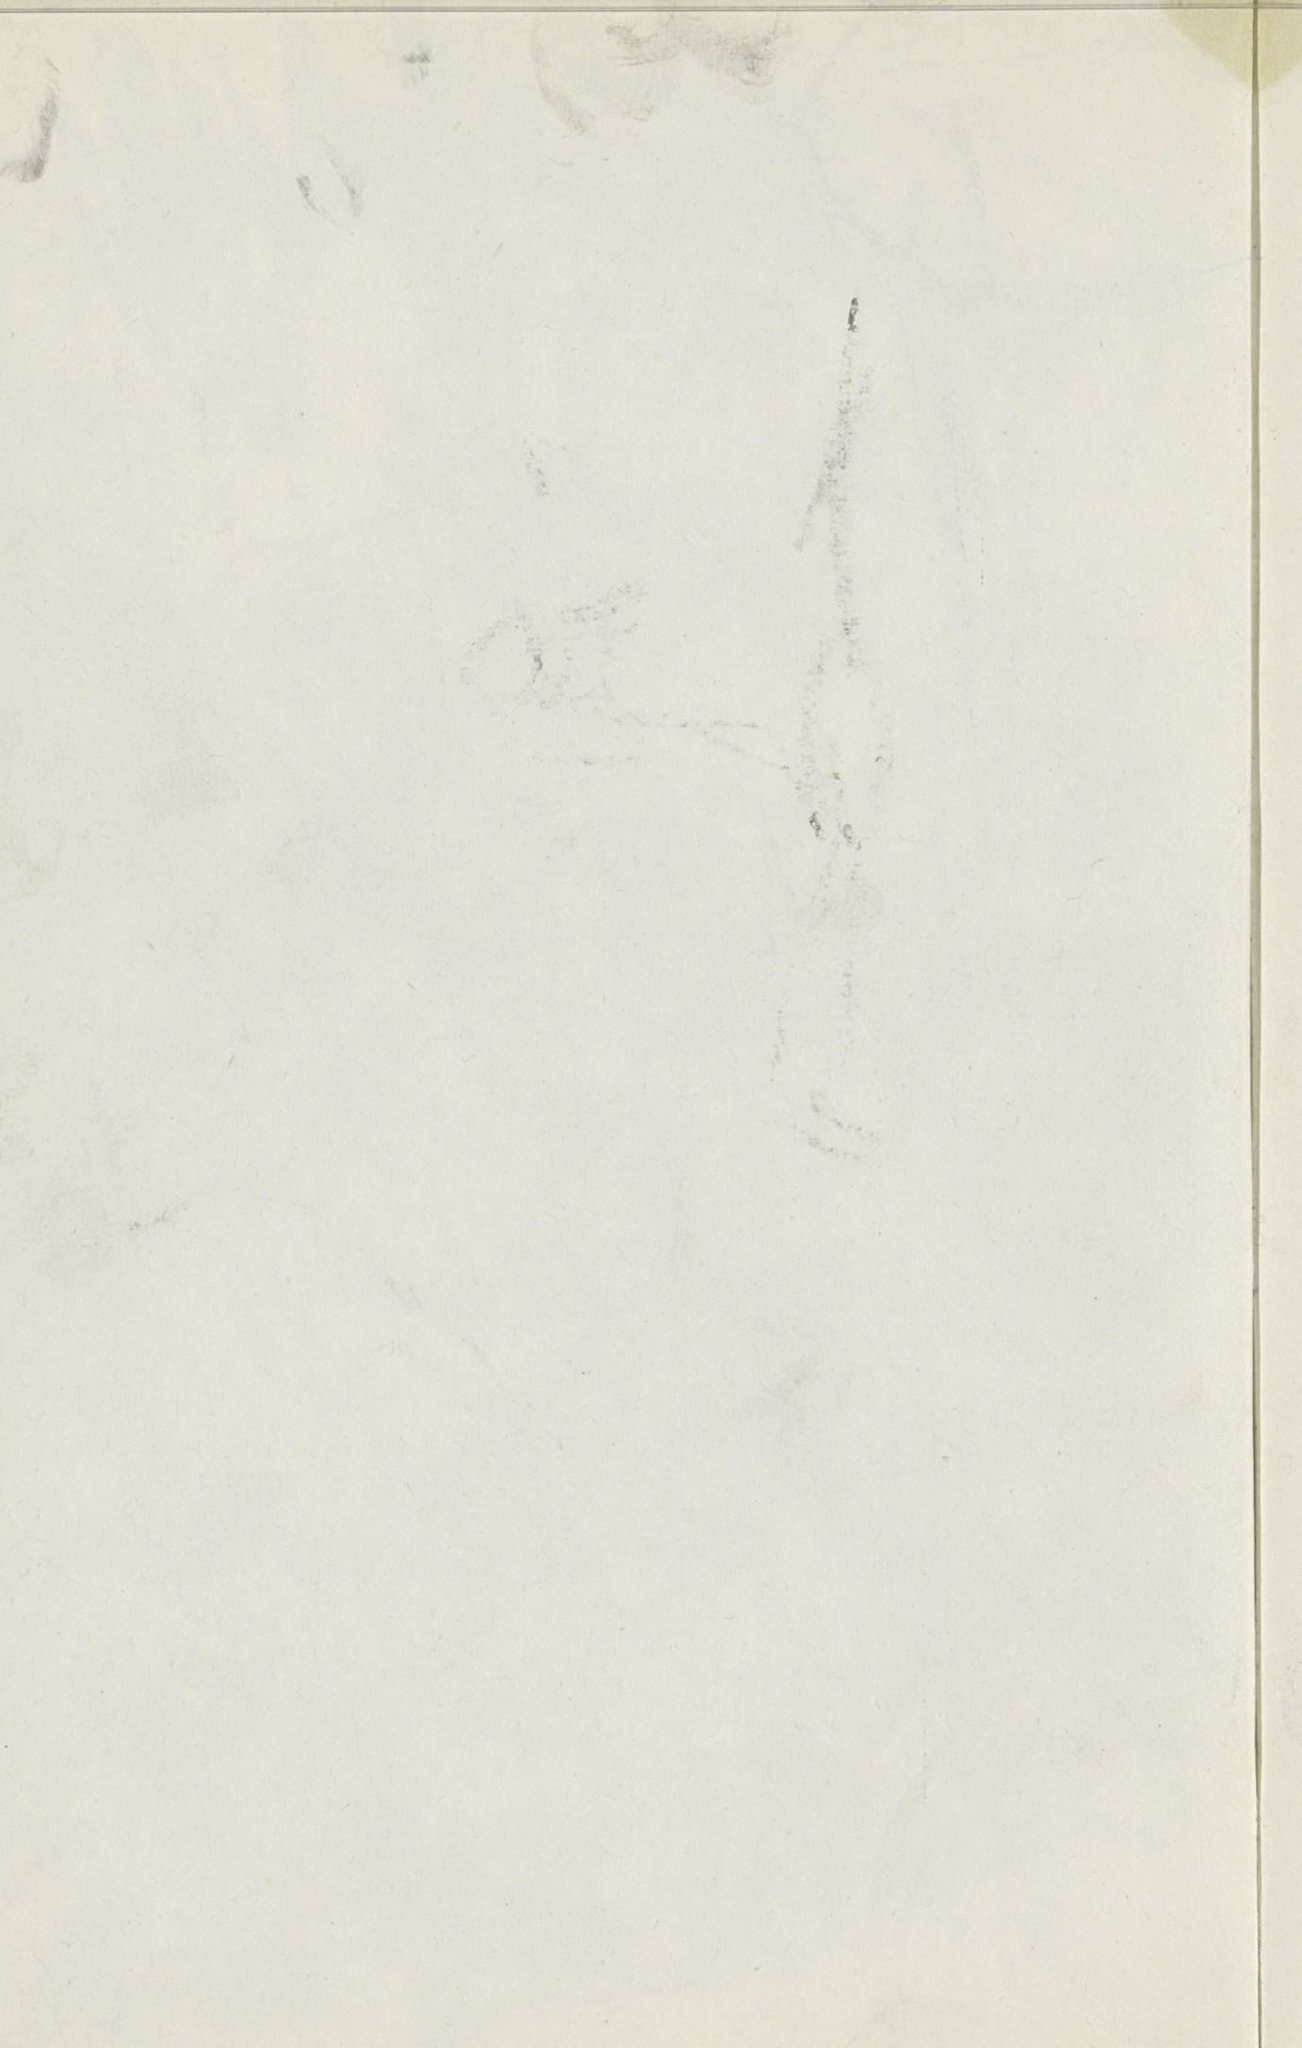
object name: sketchbook leaf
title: Ablatsch van de krijttekening op blad 18A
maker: isaac israels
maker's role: draughtsman, painter, print maker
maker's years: 1865-1934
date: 1875-1934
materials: paper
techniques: printmaking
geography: london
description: Pagina 21 en pagina 22 uit schetsboek XXXV met 36 pagina's.